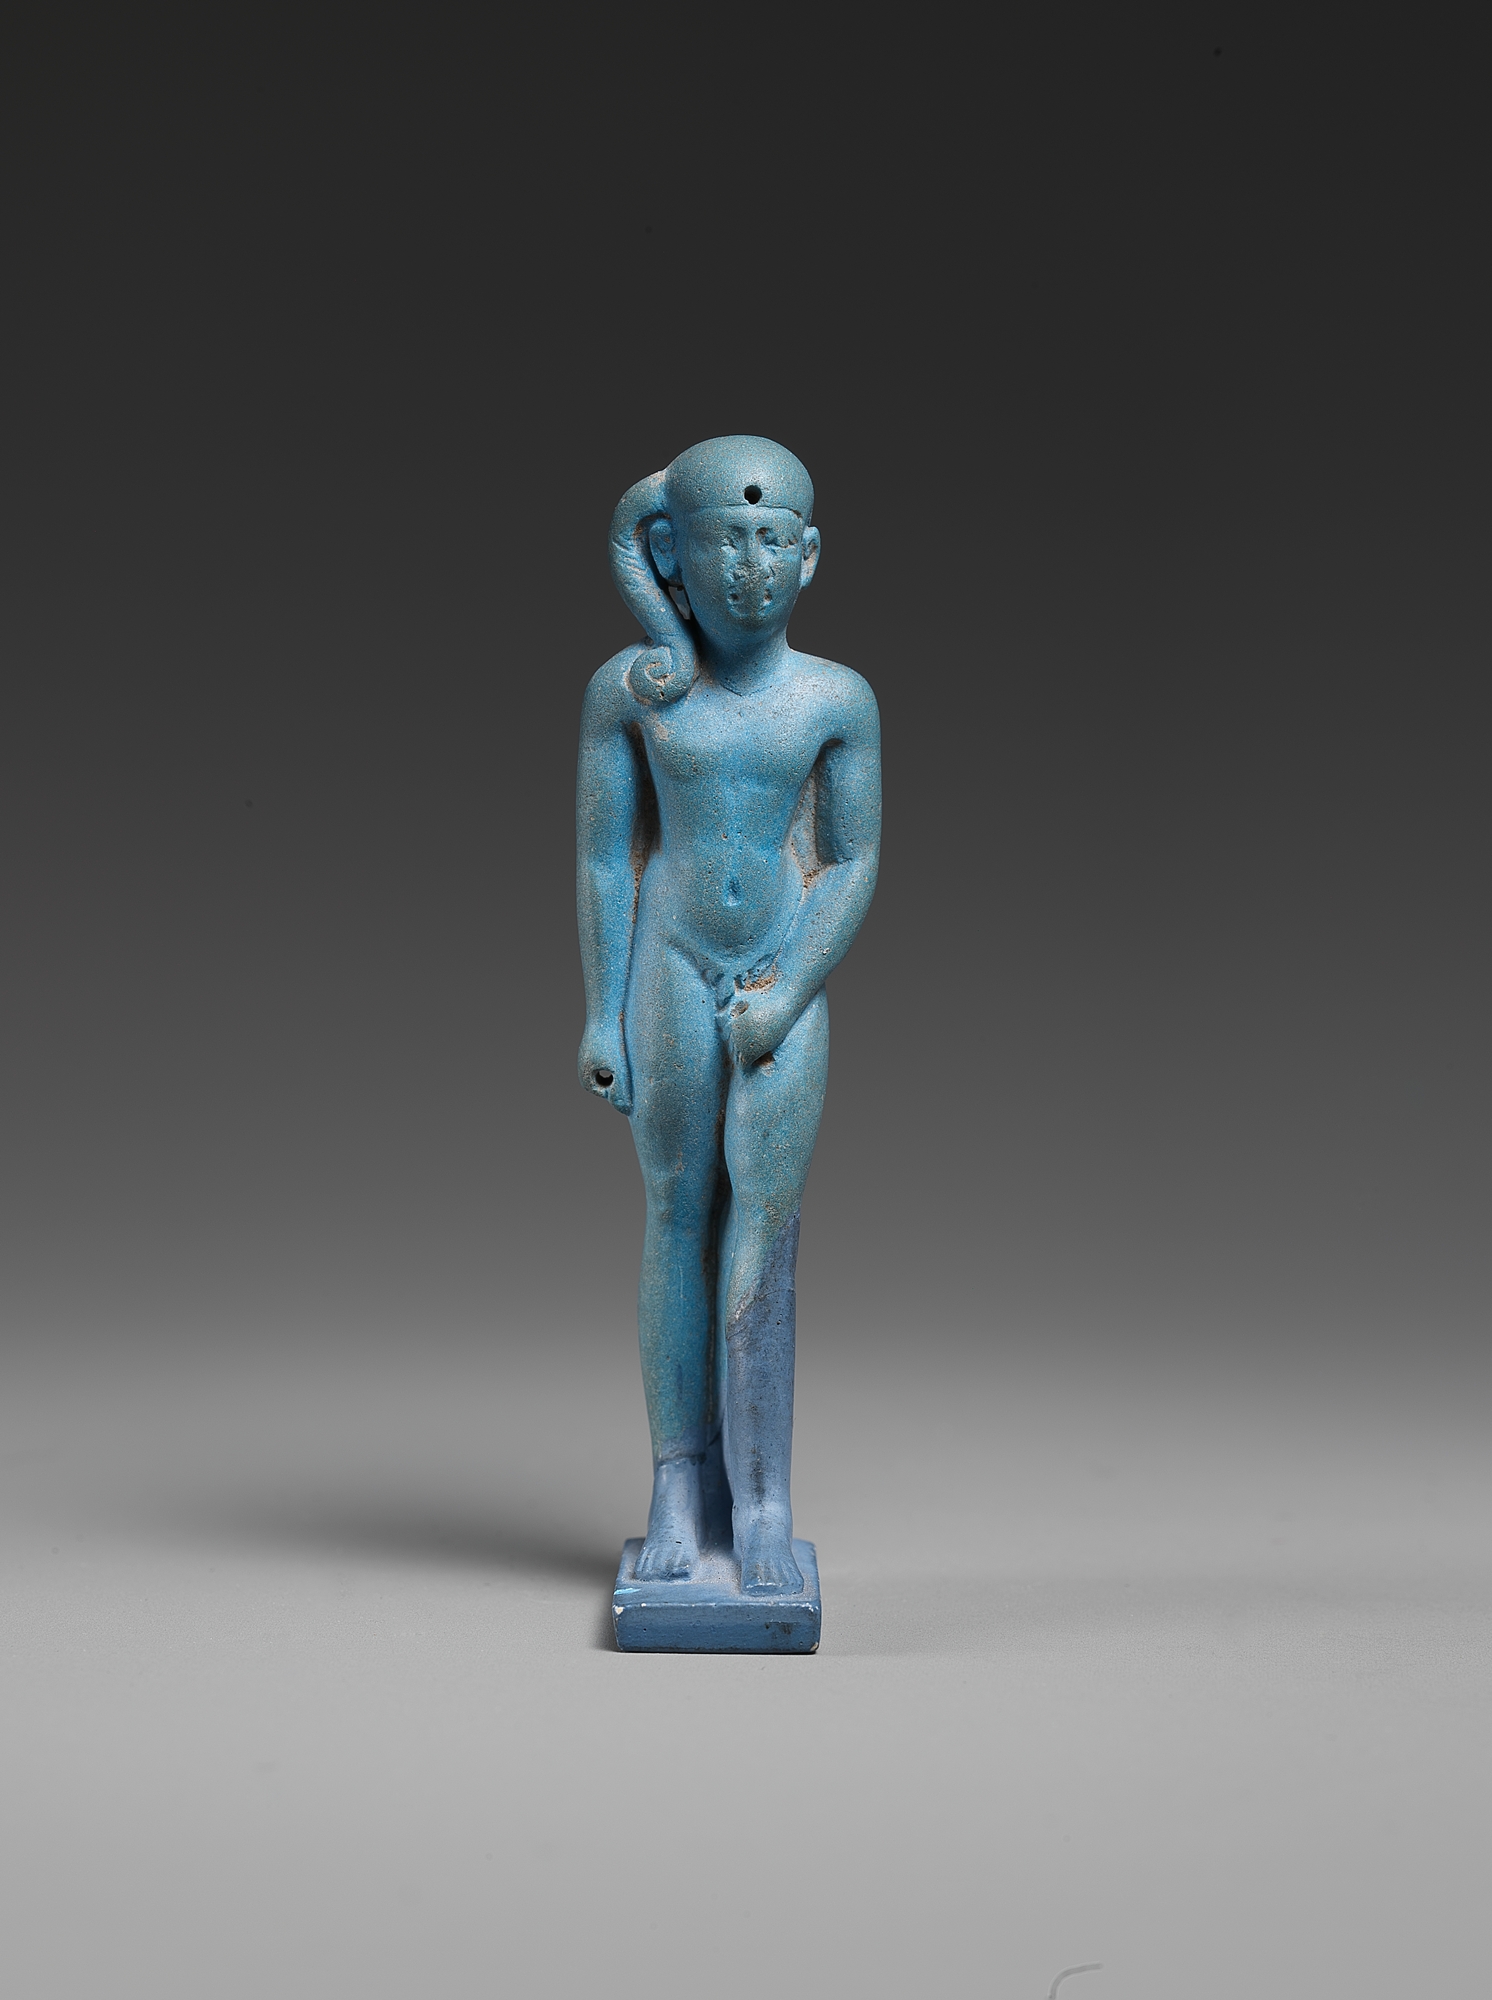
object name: amulet, harpokrates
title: Amulet: Harpokrates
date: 664-332 BCE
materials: faience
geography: egypt